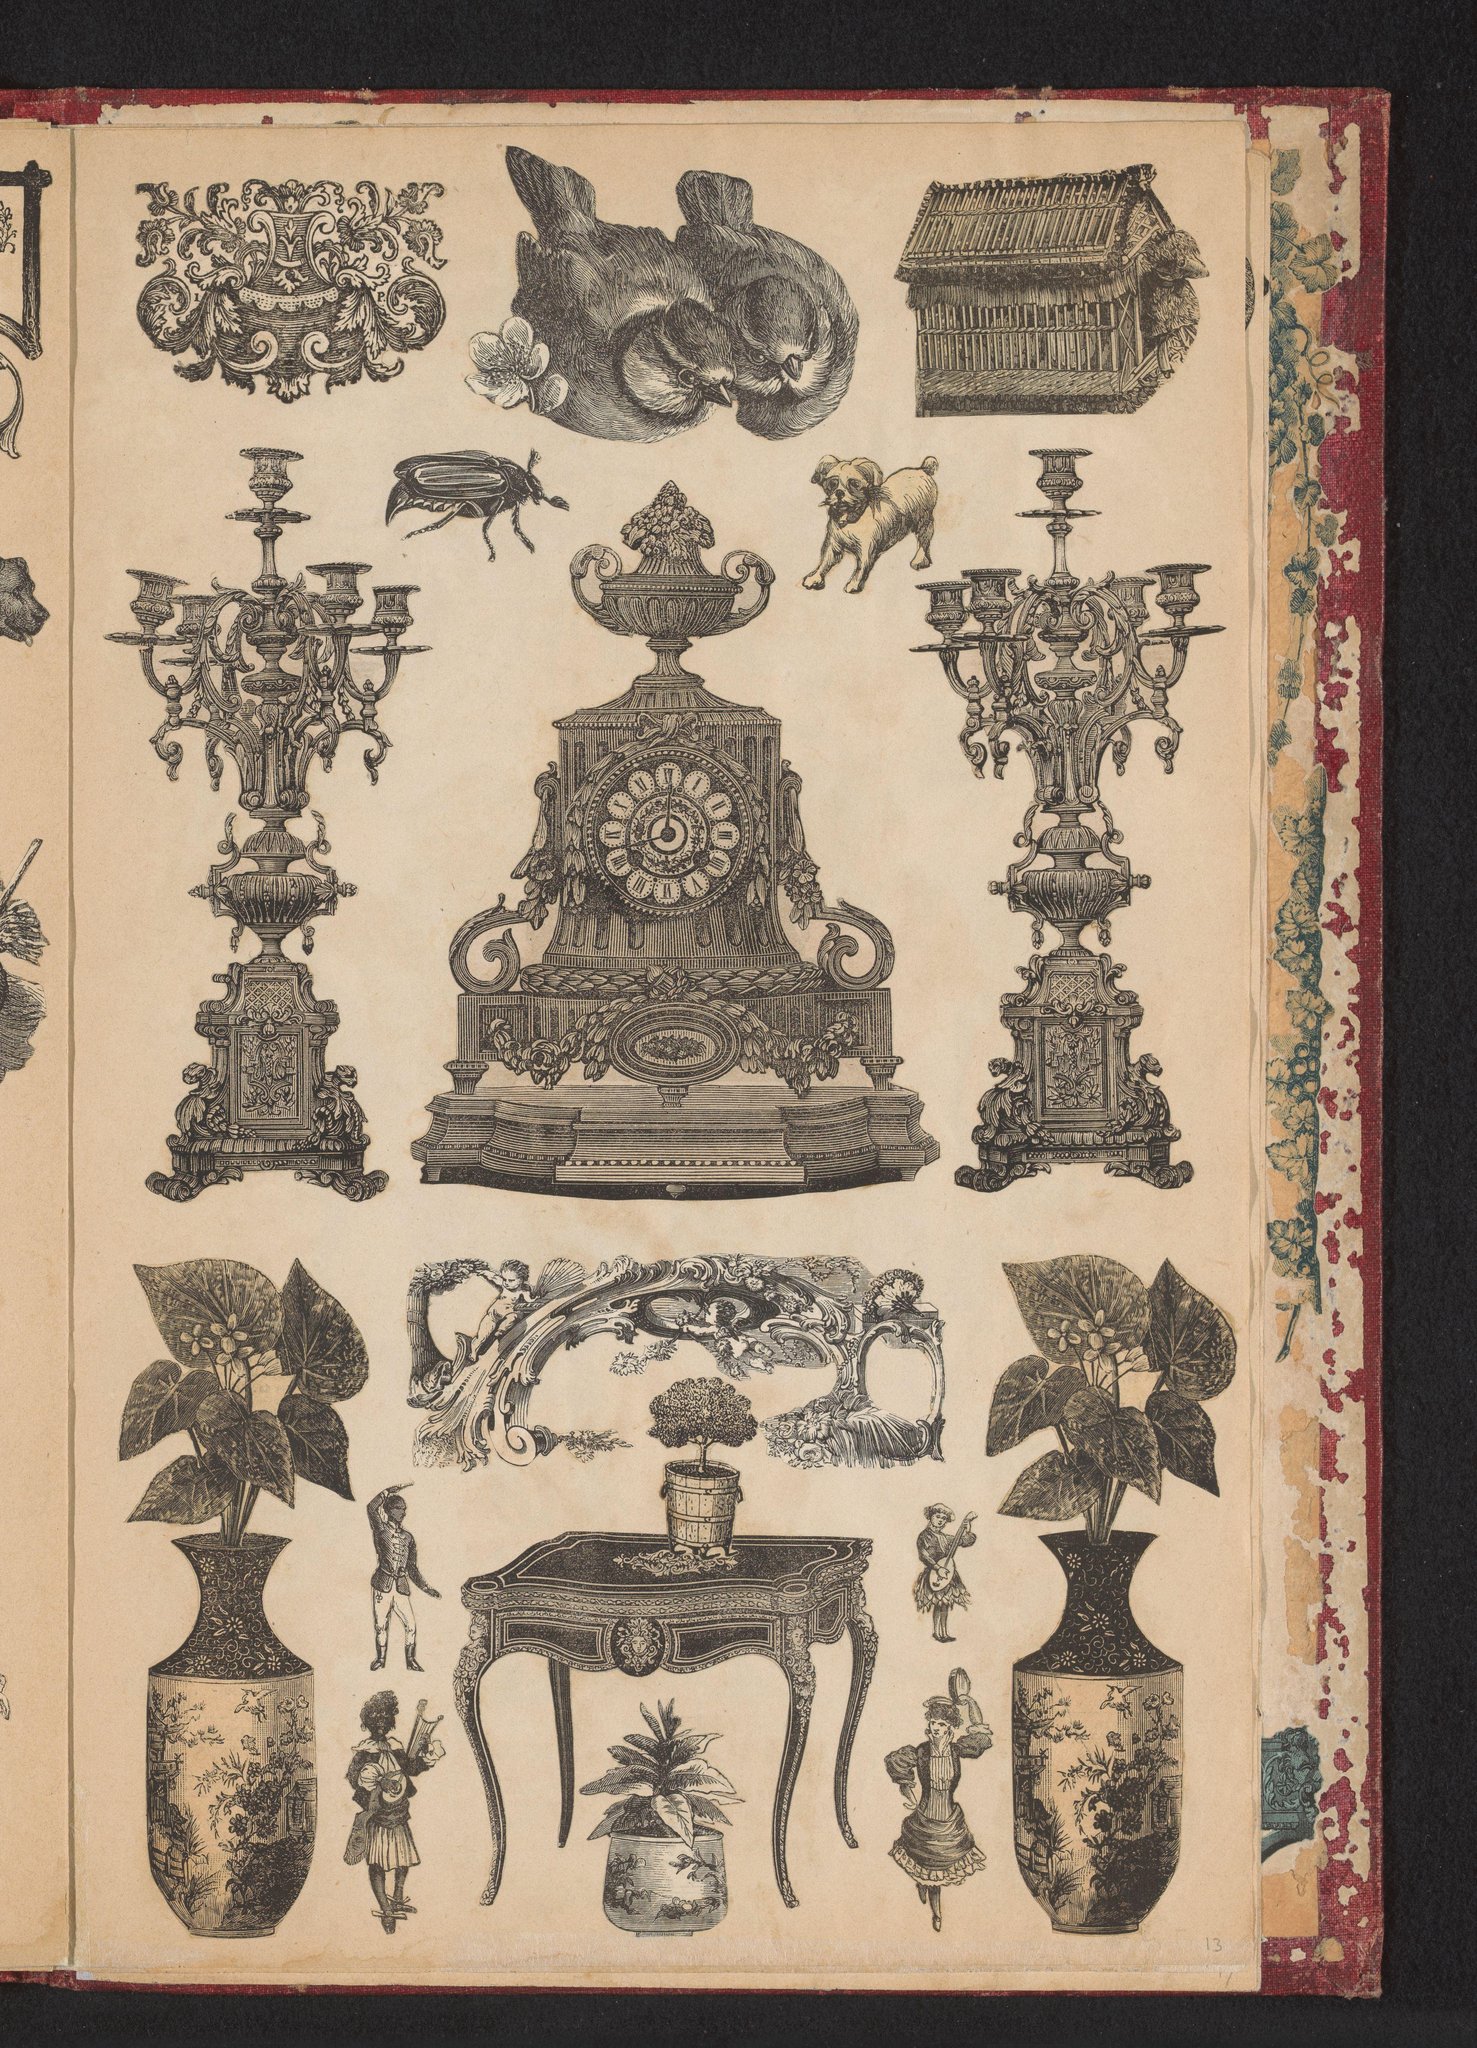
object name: collage visual work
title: Collage van uitgeknipte prenten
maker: Anonymous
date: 1870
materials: paper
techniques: engraving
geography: paris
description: Collage van uitgeknipte prenten. Onderdeel van een album met 18 bladen, aan beide zijden beplakt met uitgeknipte prenten, vermoedelijk afkomstig uit 19e-eeuwse tijdschiften.